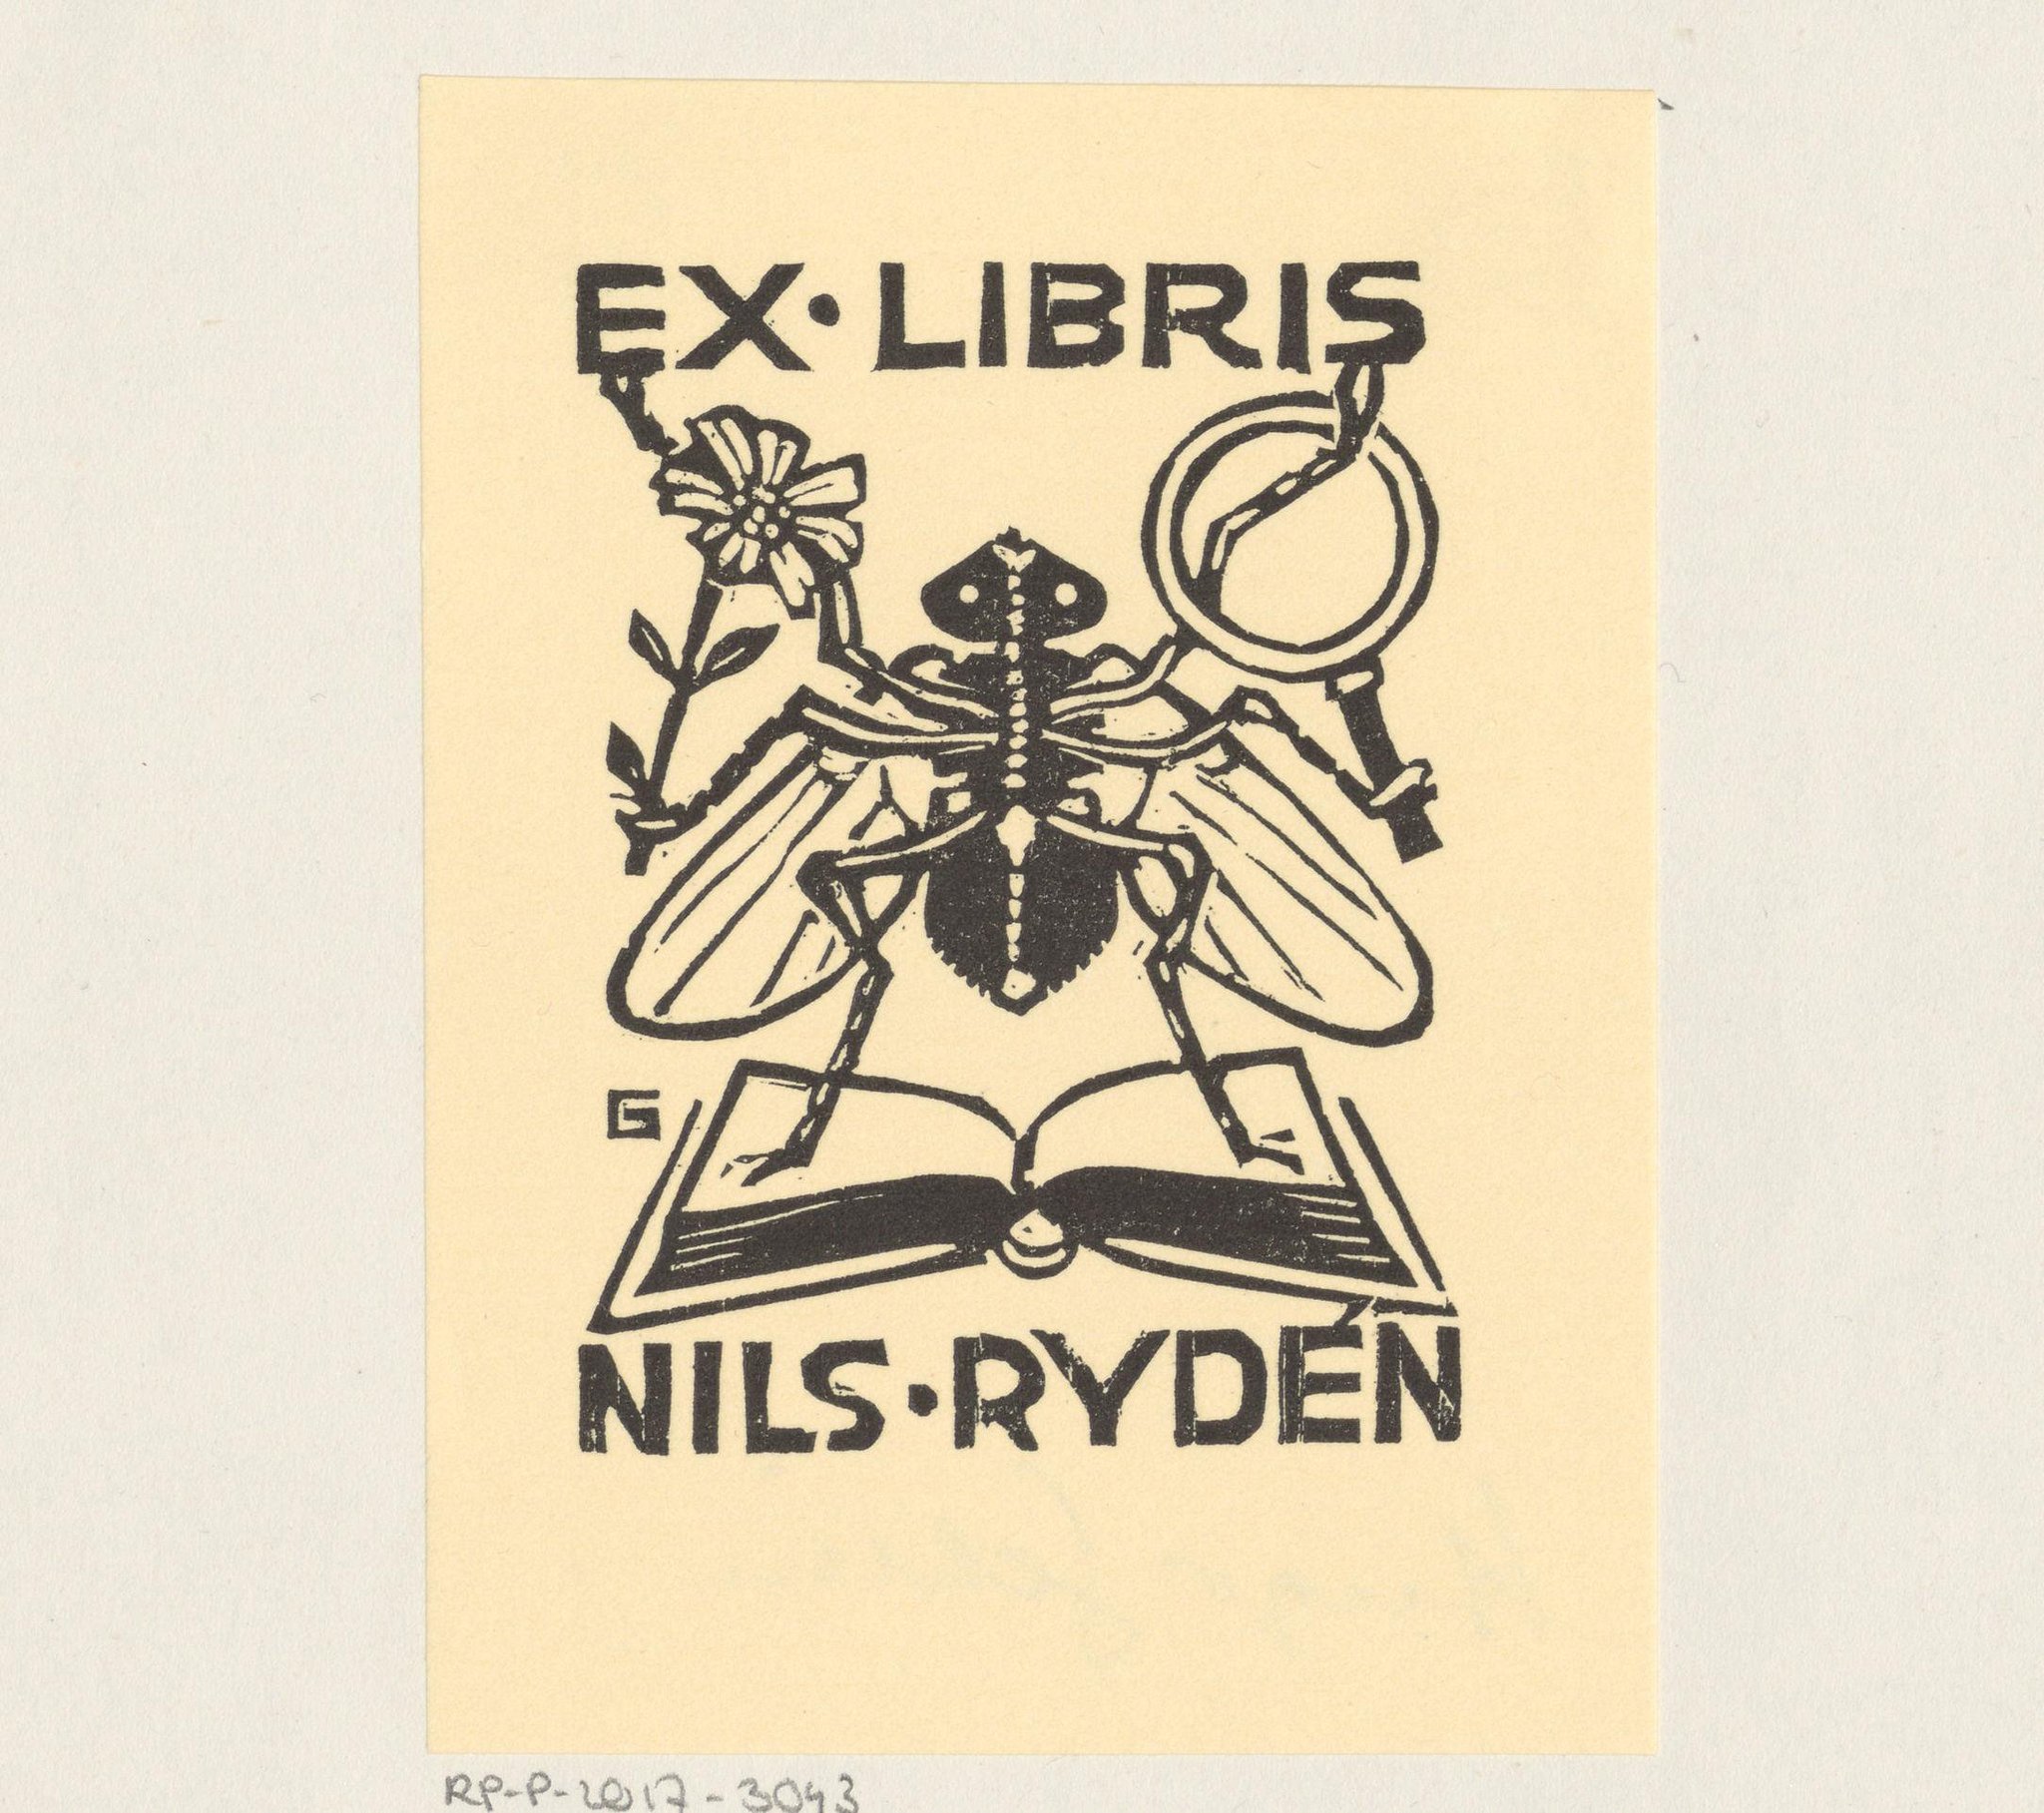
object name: bookplate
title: Ex libris van Nils Rydén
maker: hugo gehlin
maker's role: painter, print maker, sculptor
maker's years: 1889-1953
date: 1899-1953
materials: paper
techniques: woodcut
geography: sweden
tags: flowers, magnifying glass, book, insects: fly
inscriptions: inscription: ‘Hugo Gehlin’